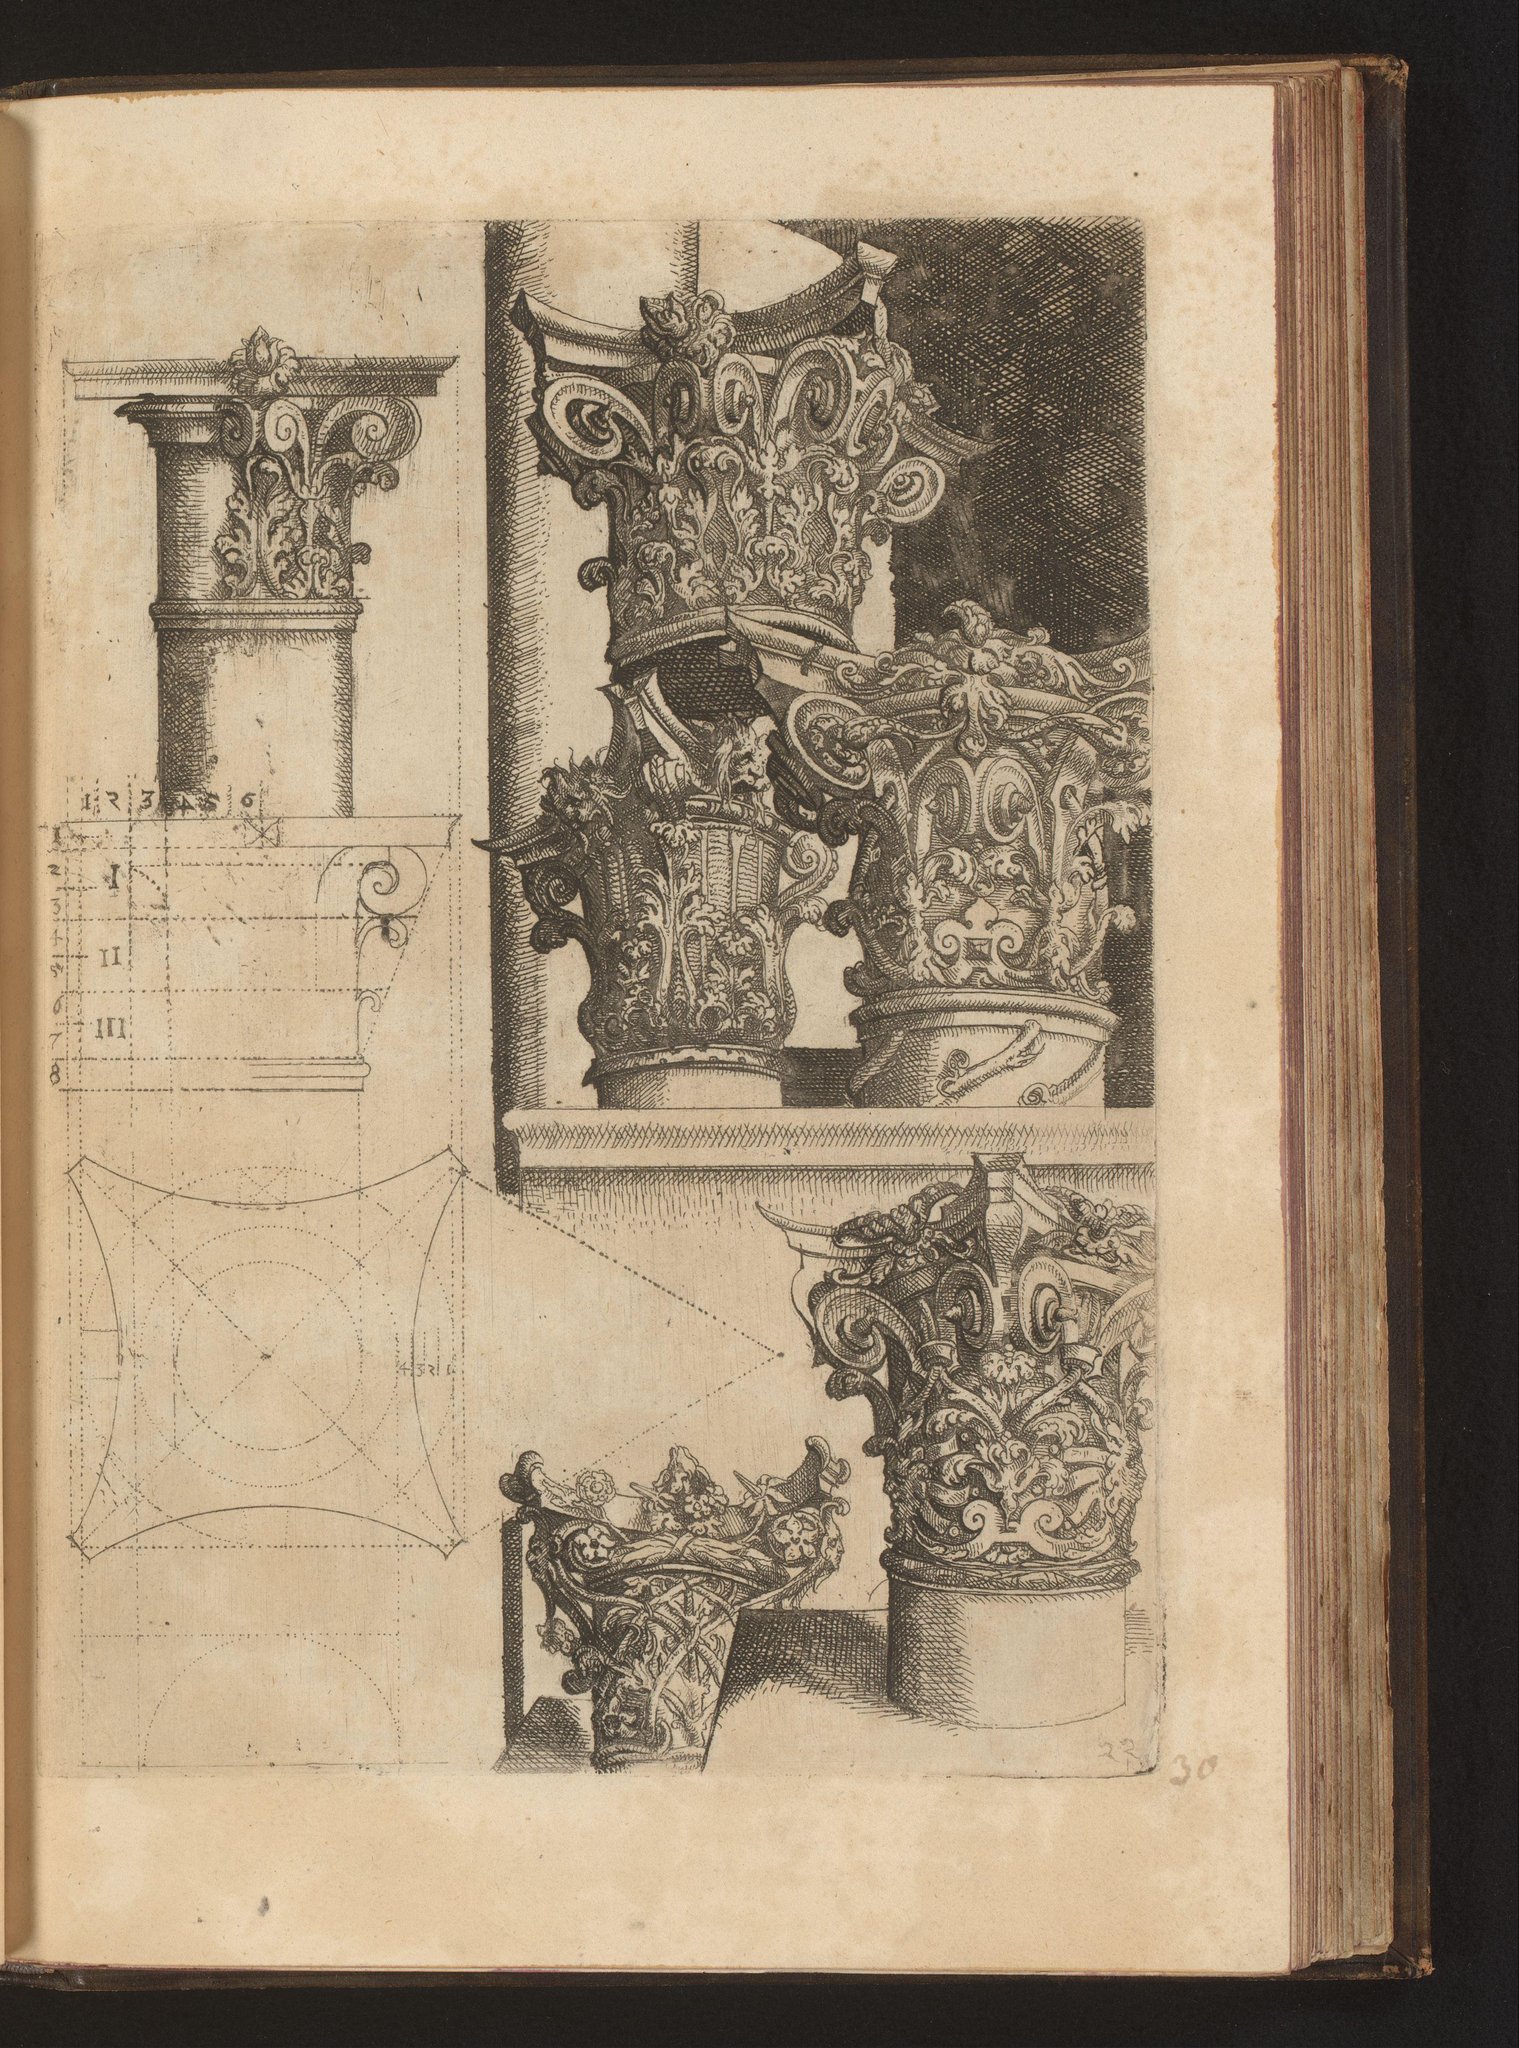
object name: page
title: Architectura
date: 1593-1595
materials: paper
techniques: etching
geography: straatsburg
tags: column, pillar ~ architecture, other architectural details, capital (~ column, pillar), corinthian order ~ architecture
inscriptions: collector's mark: Lugt 2228, collector's mark: Lugt 2760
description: Prent gebruikt in: Dietterlin, Wendel (I). Architectura de quinq[ue] columnarum simmetrica distributione et variis eorundem or namentis: Liber I. Straatsburg: Bernhard Jobin, 1593.